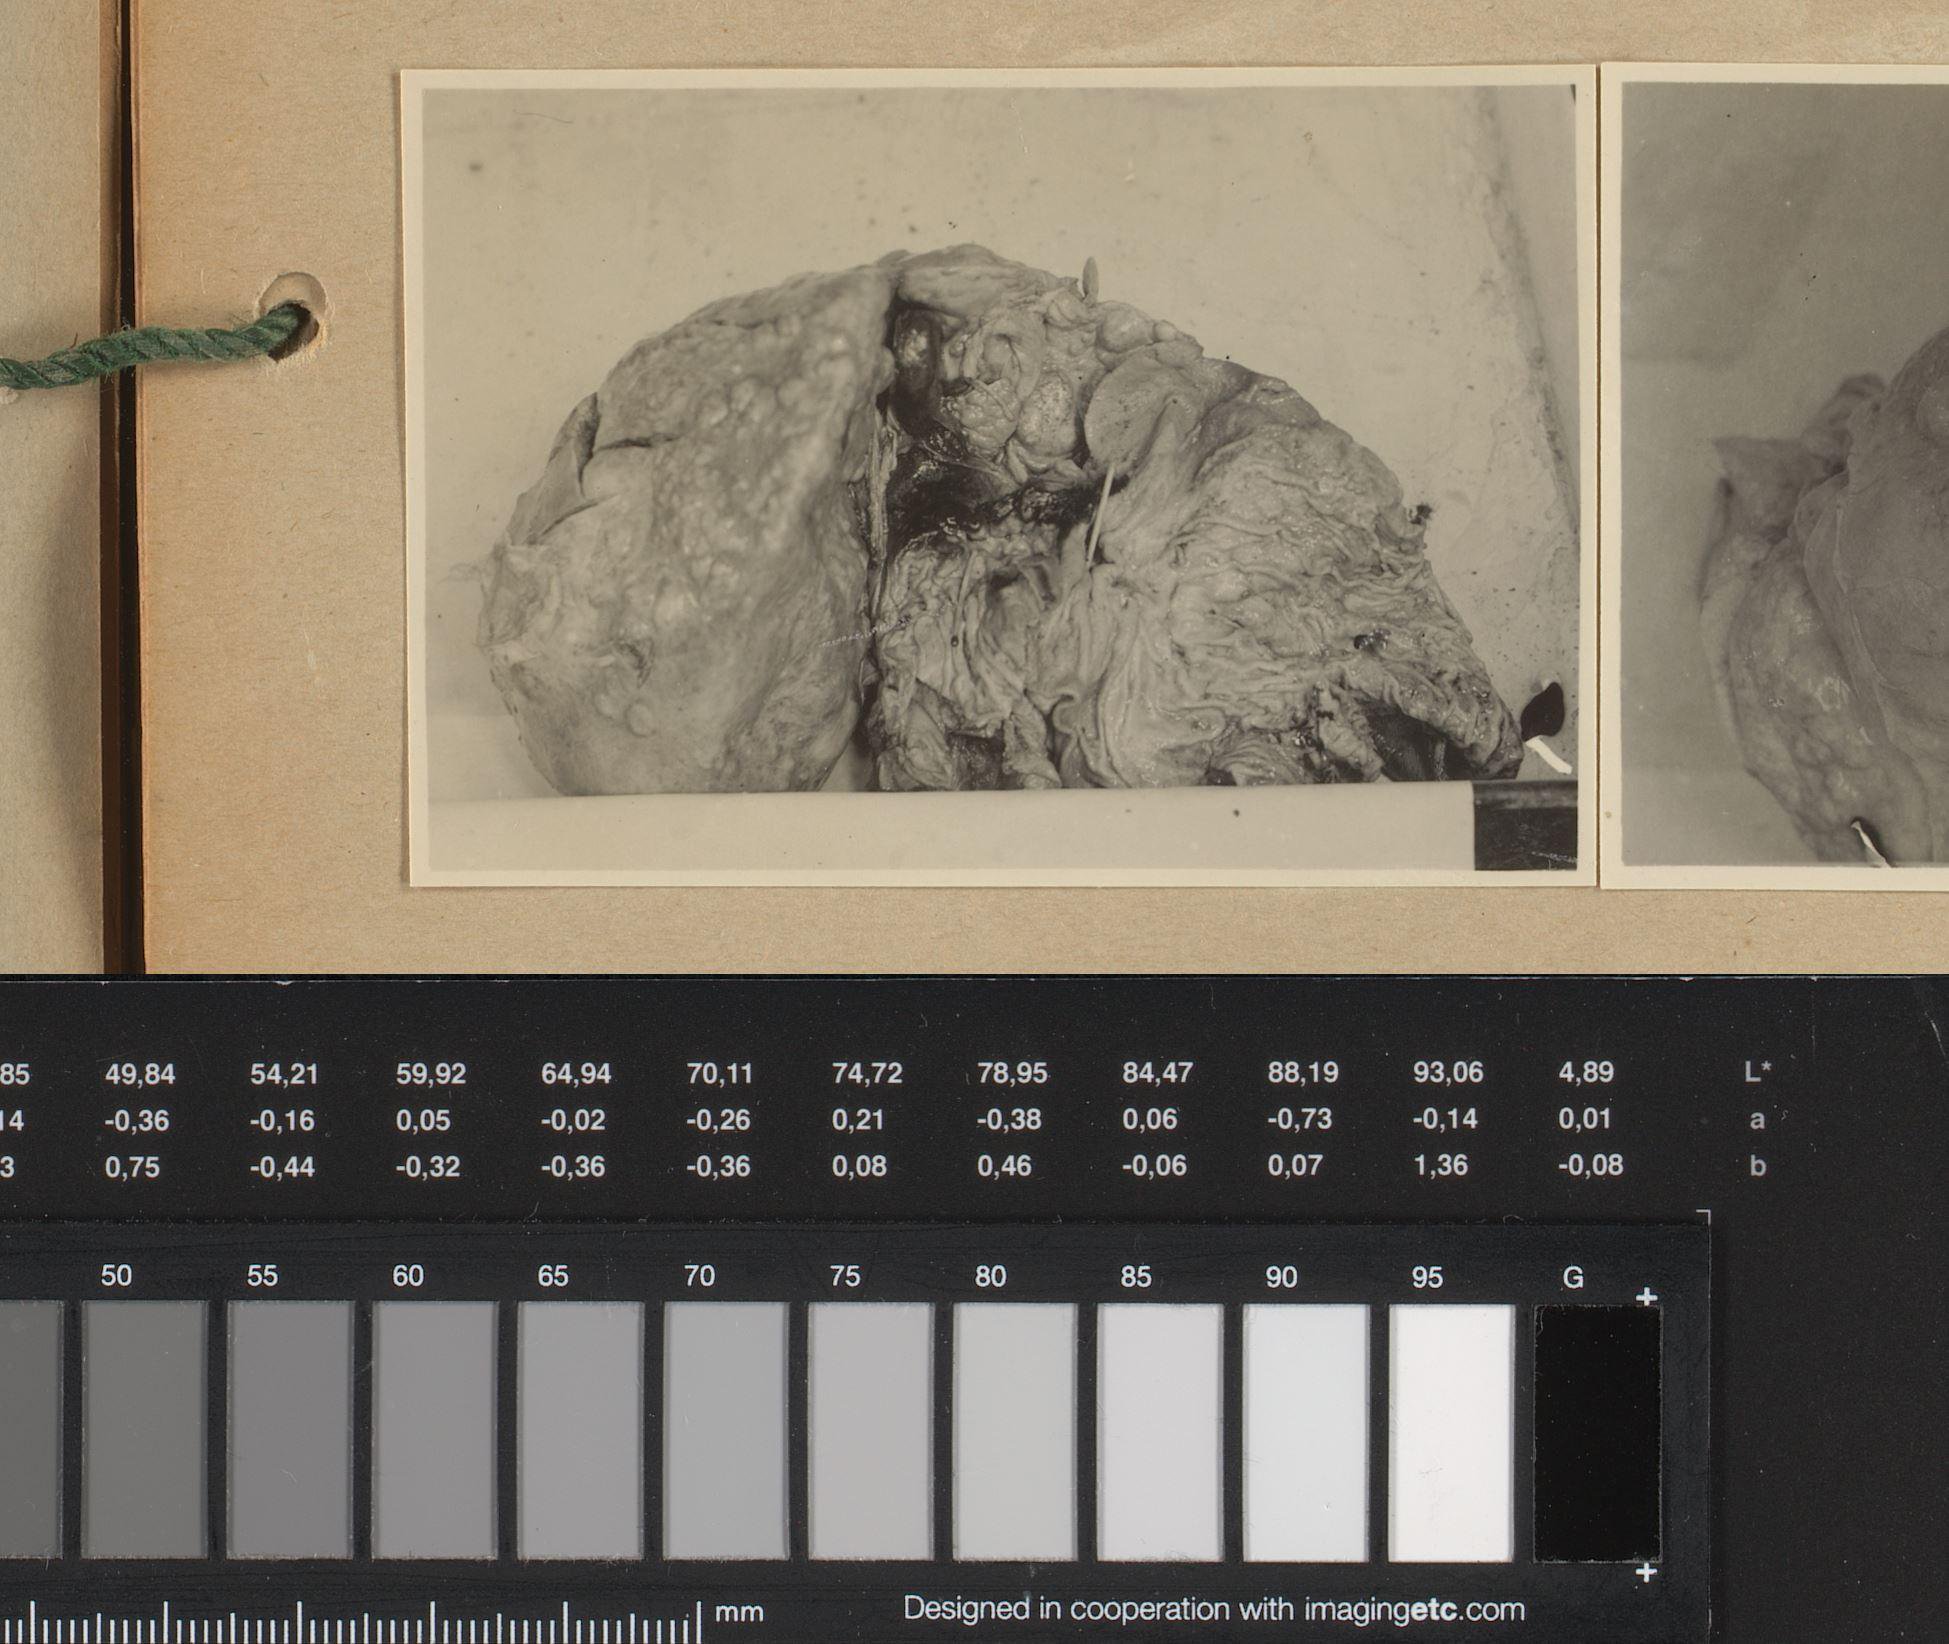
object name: photograph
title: Pathologische anatomie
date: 1929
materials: cardboard, photographic support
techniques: gelatin silver print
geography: kabanjahe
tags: colonial system, patient, sick person, anatomical specimen, sumatra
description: Medische foto (a) van maag en lever met tumoren van een man genaamd Si Koewala Simbiring van ca. 40-45 jaar, na sectie op de afdeling Pathologische anatomie. Datum foto: 12 september 1929. Foto geplakt op voorgedrukt kartonnen blad ingebonden in het fotoalbum over het Hospitaal Batak Instituut te Kabanjaheh op Sumatra in de jaren 1926-1929.